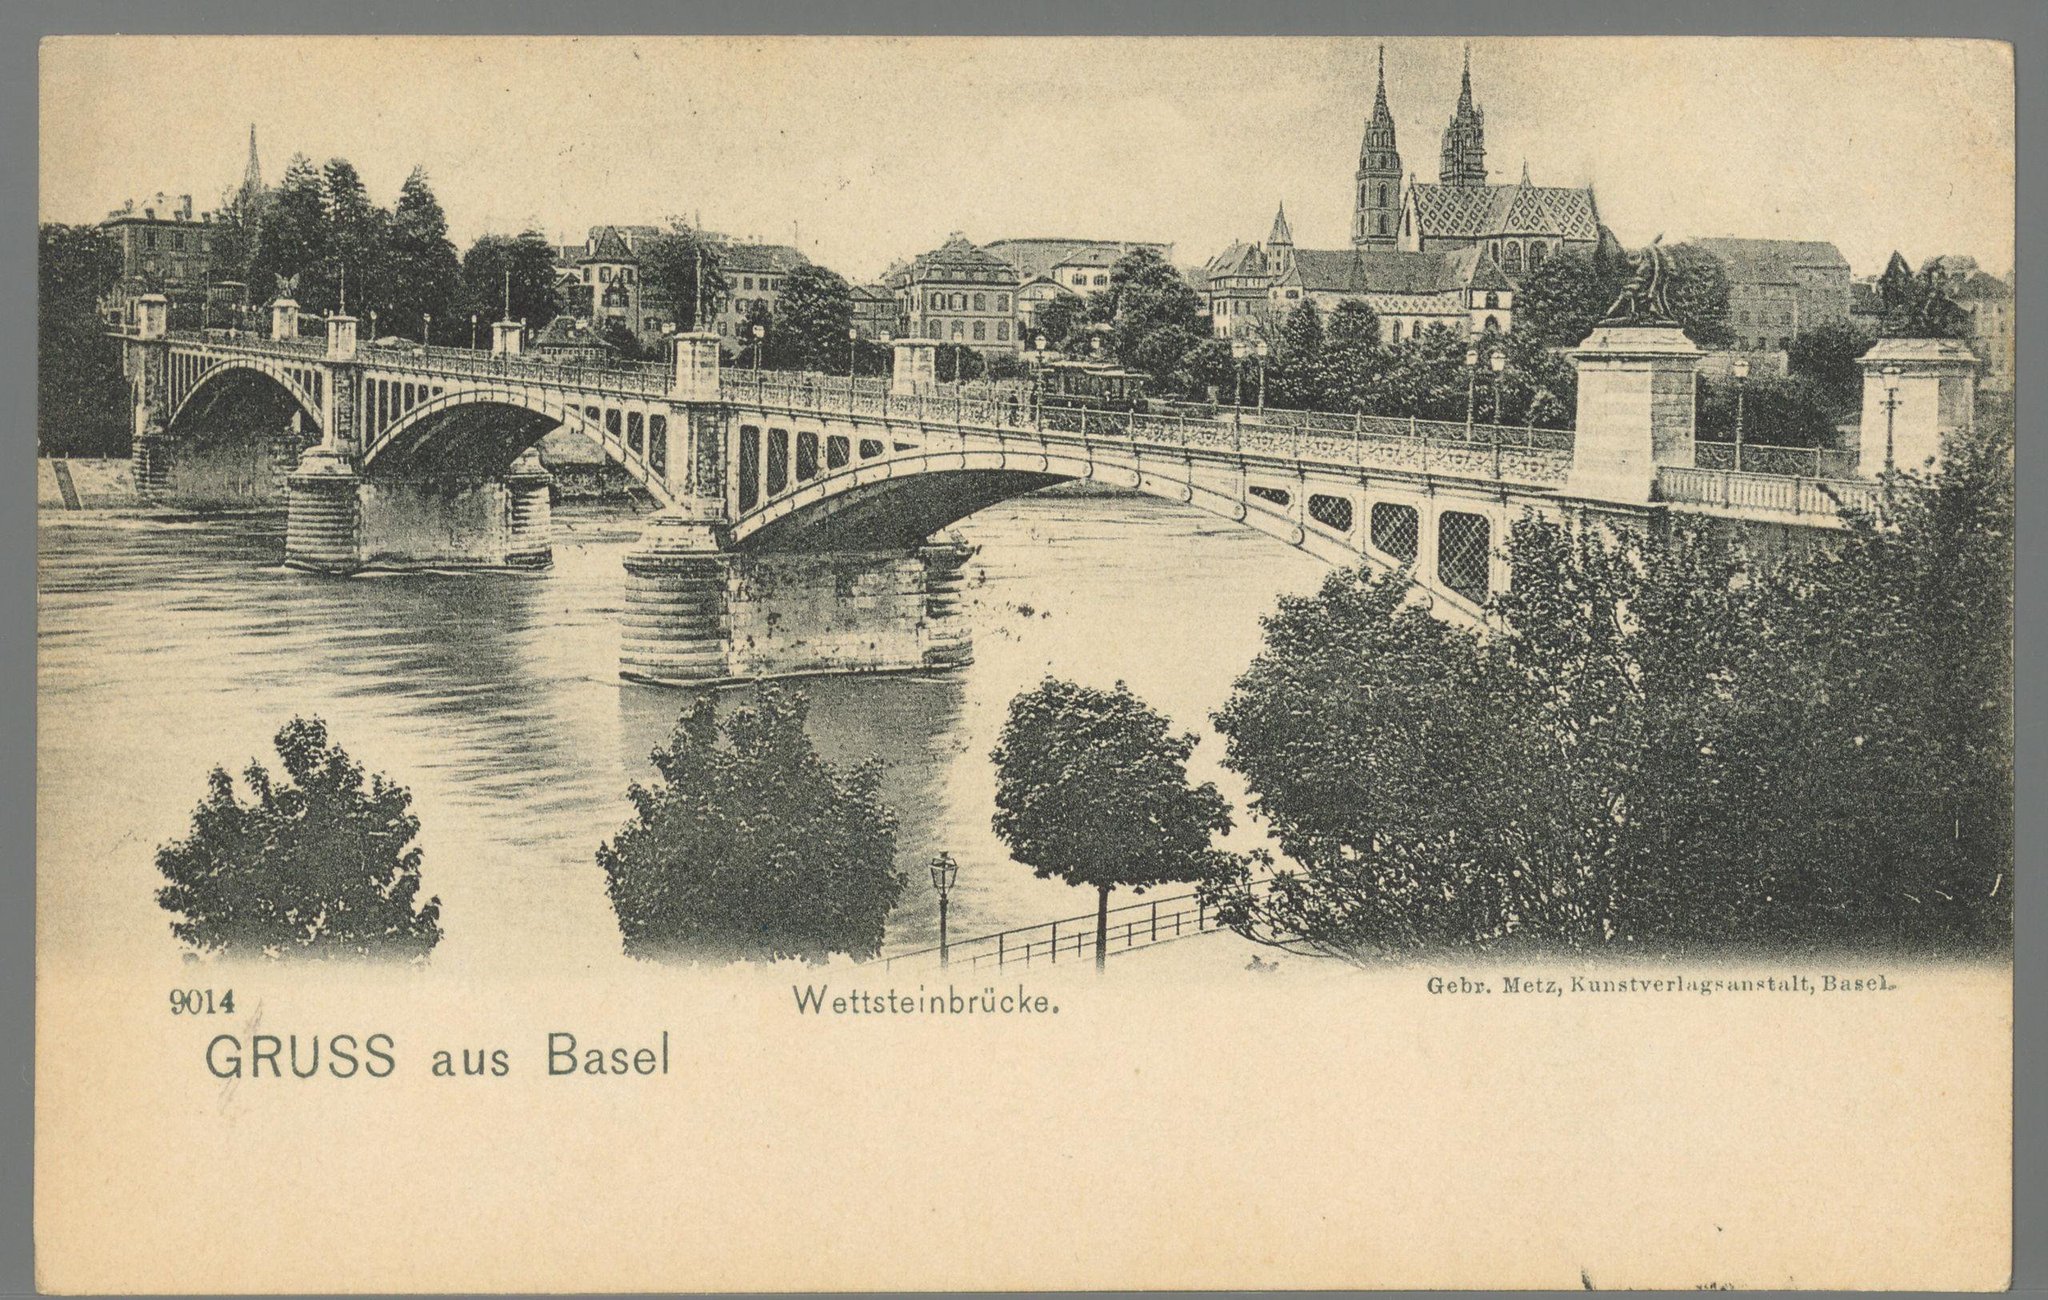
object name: ansichtkaart, prentbriefkaart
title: Gruss aus Basel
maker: Anonymous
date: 1897-1902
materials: cardboard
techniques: photograph, writing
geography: basel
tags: river, bridge in city across river, canal, etc., prospect of city, town panorama, silhouette of city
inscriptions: postage stamp